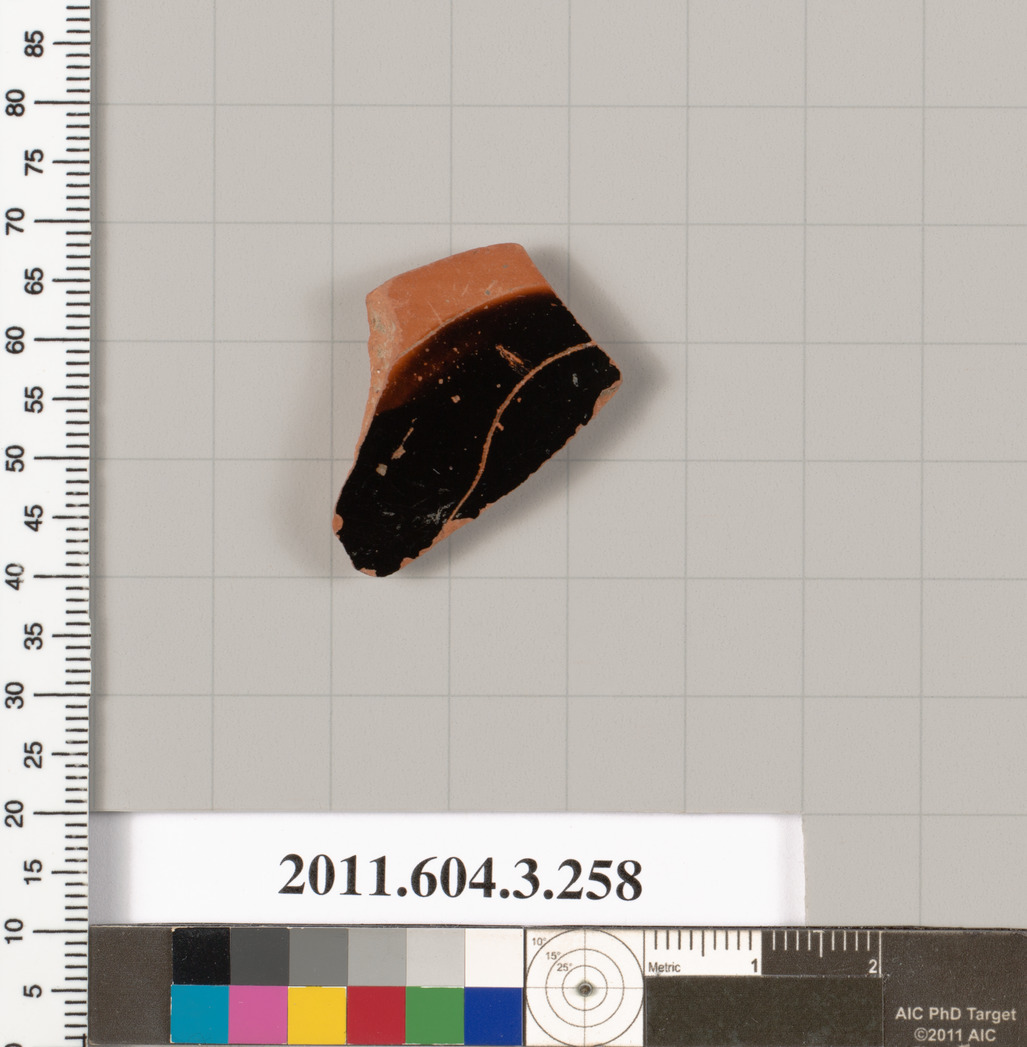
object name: neck amphora fragment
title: Terracotta fragment of a neck-amphora (jar)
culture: greek, attic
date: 510-500 BCE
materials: terracotta